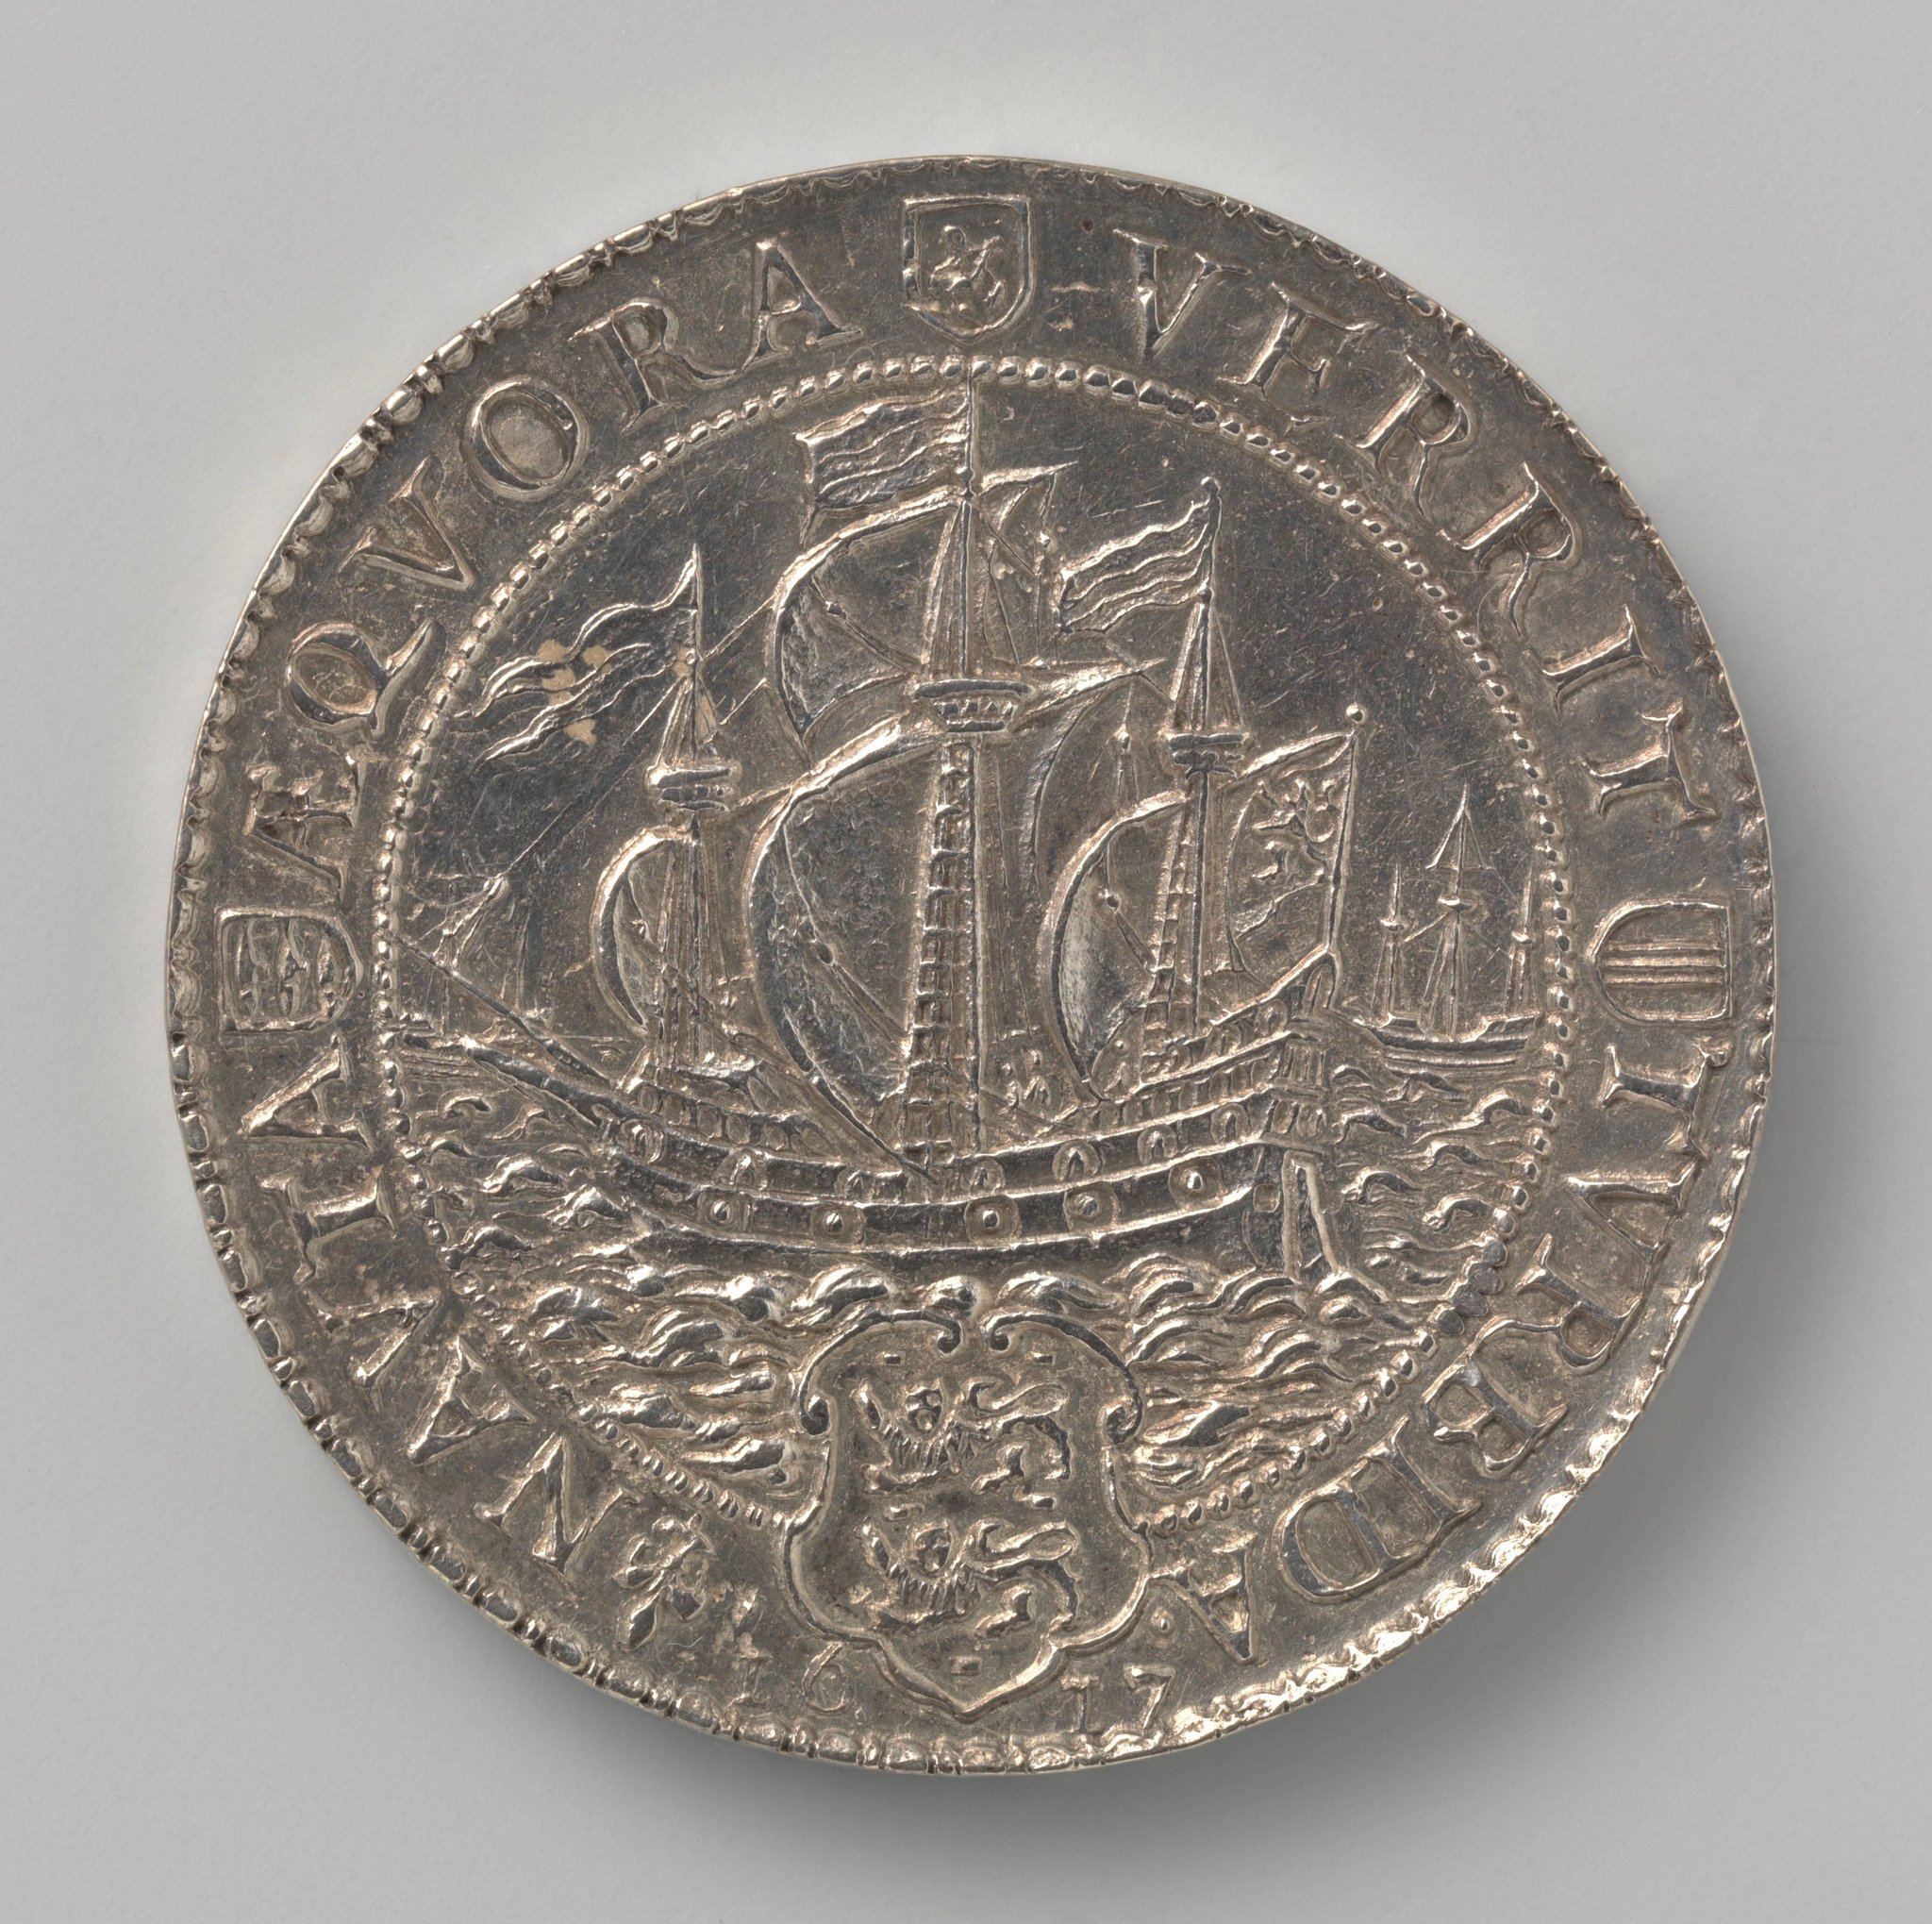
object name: history medal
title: Prosperity of West Friesland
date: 1617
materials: silver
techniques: striking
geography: west frisia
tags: hoorn (north holland), theodorus velius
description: Commemorating Dutch liberty. Many medals were made to commemorate important events or people. The Dutch revolt against the Spanish king that began in 1568 and the ups and downs of the independent Dutch Republic, which existed from 1588, were ample reasons for striking medals.